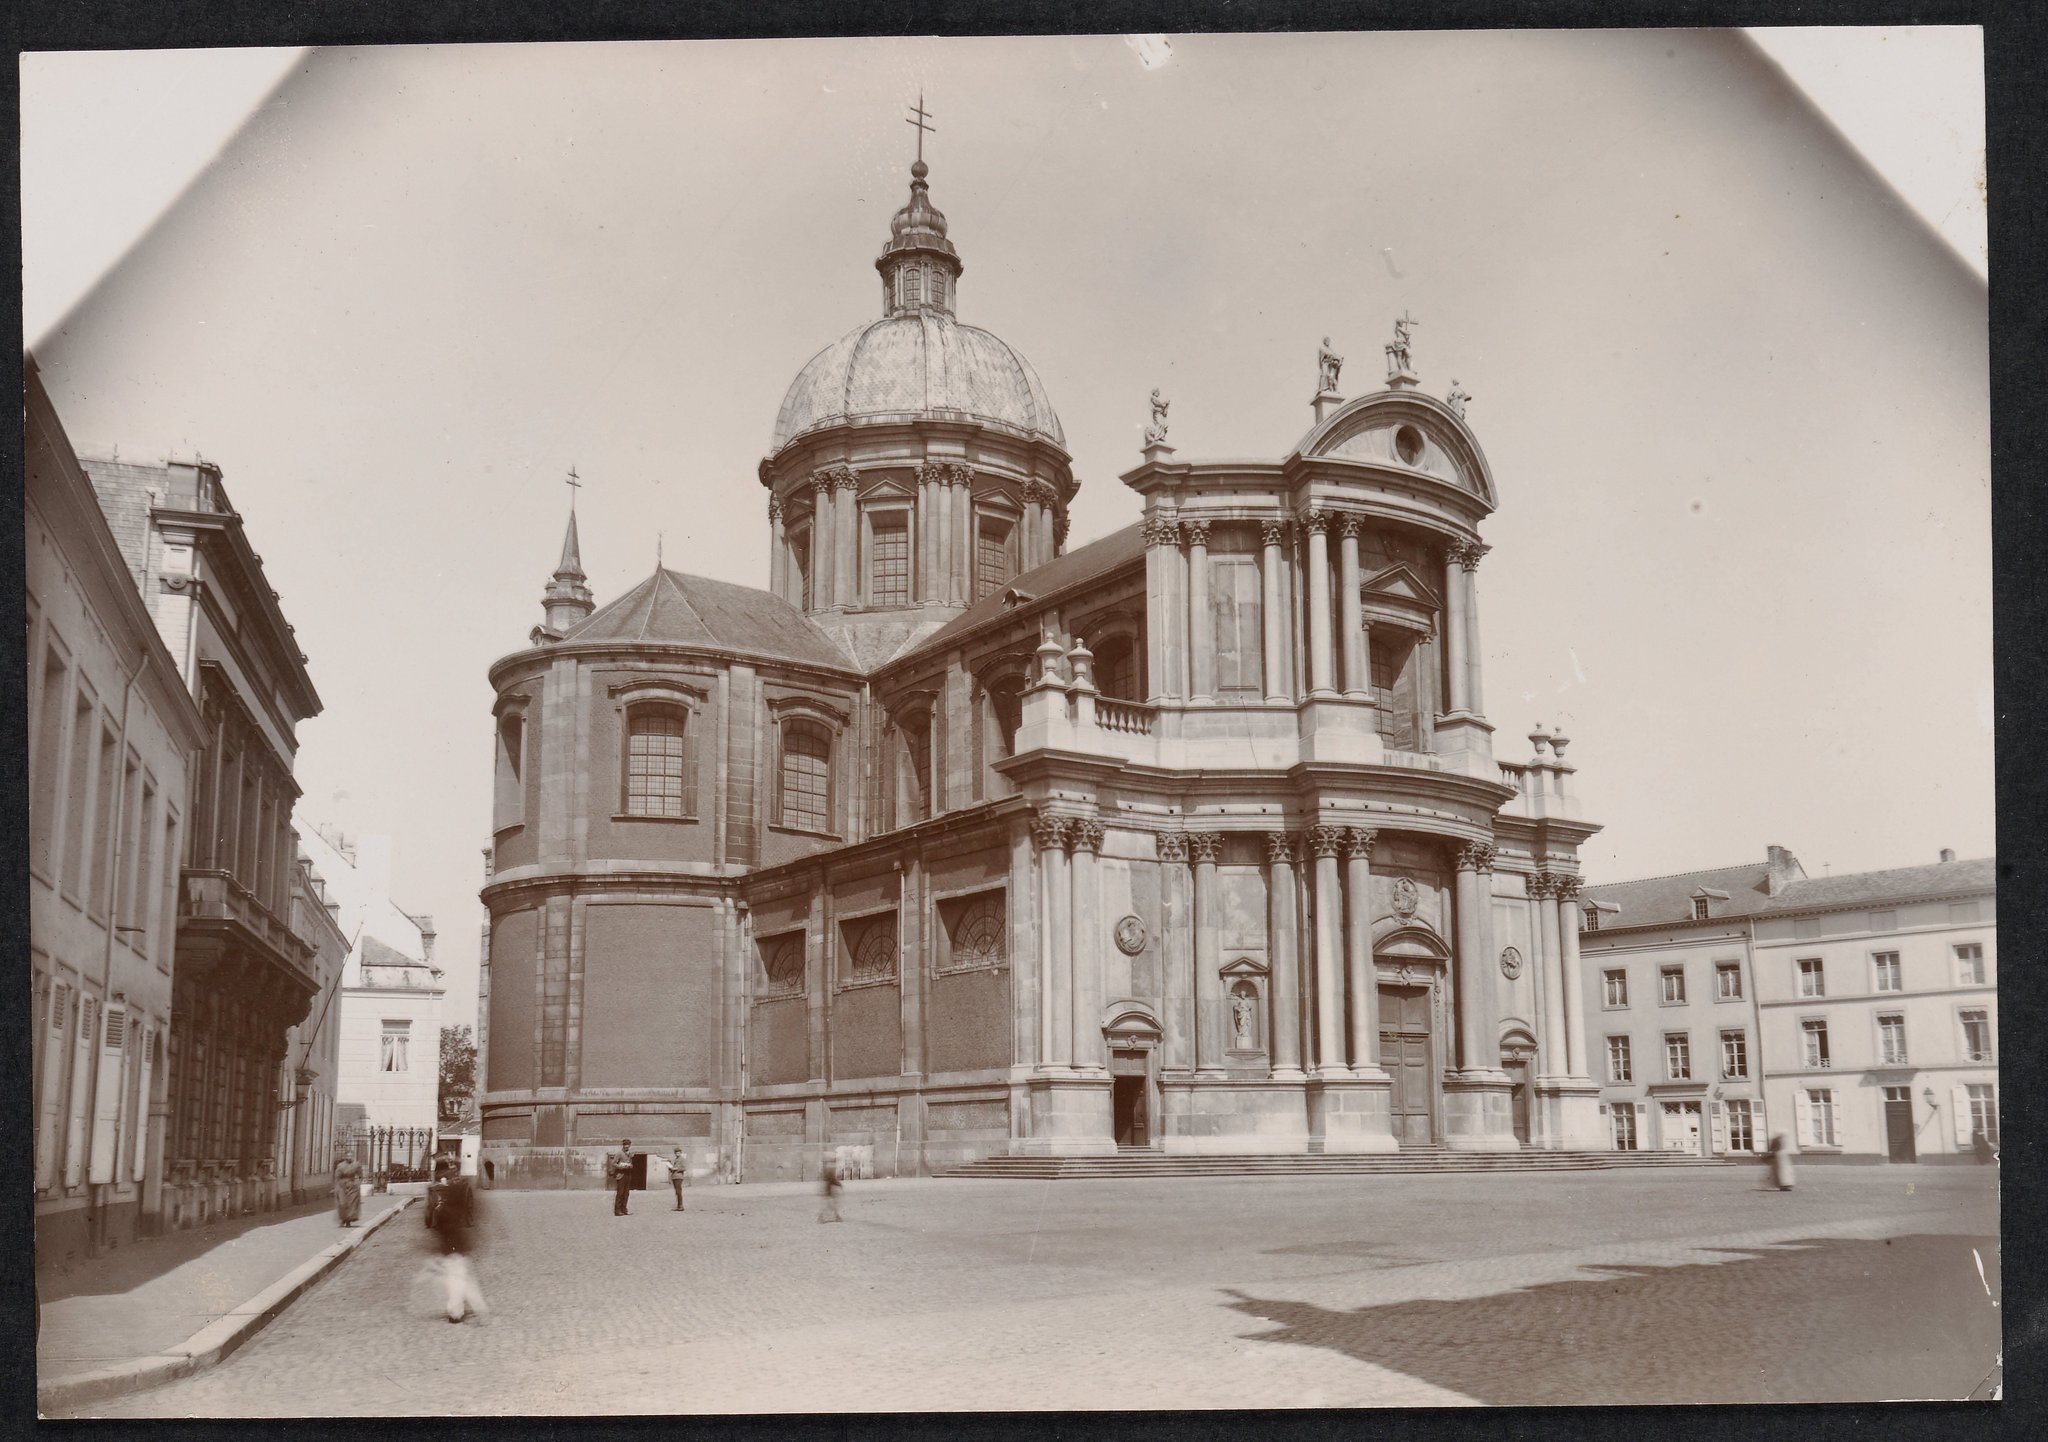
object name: photograph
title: Namur. Cathedrale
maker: Anonymous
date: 1880-1920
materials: photographic support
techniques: collodion silver print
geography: namur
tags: square, place, circus, etc., church (exterior)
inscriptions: inscription: ‘es 75’